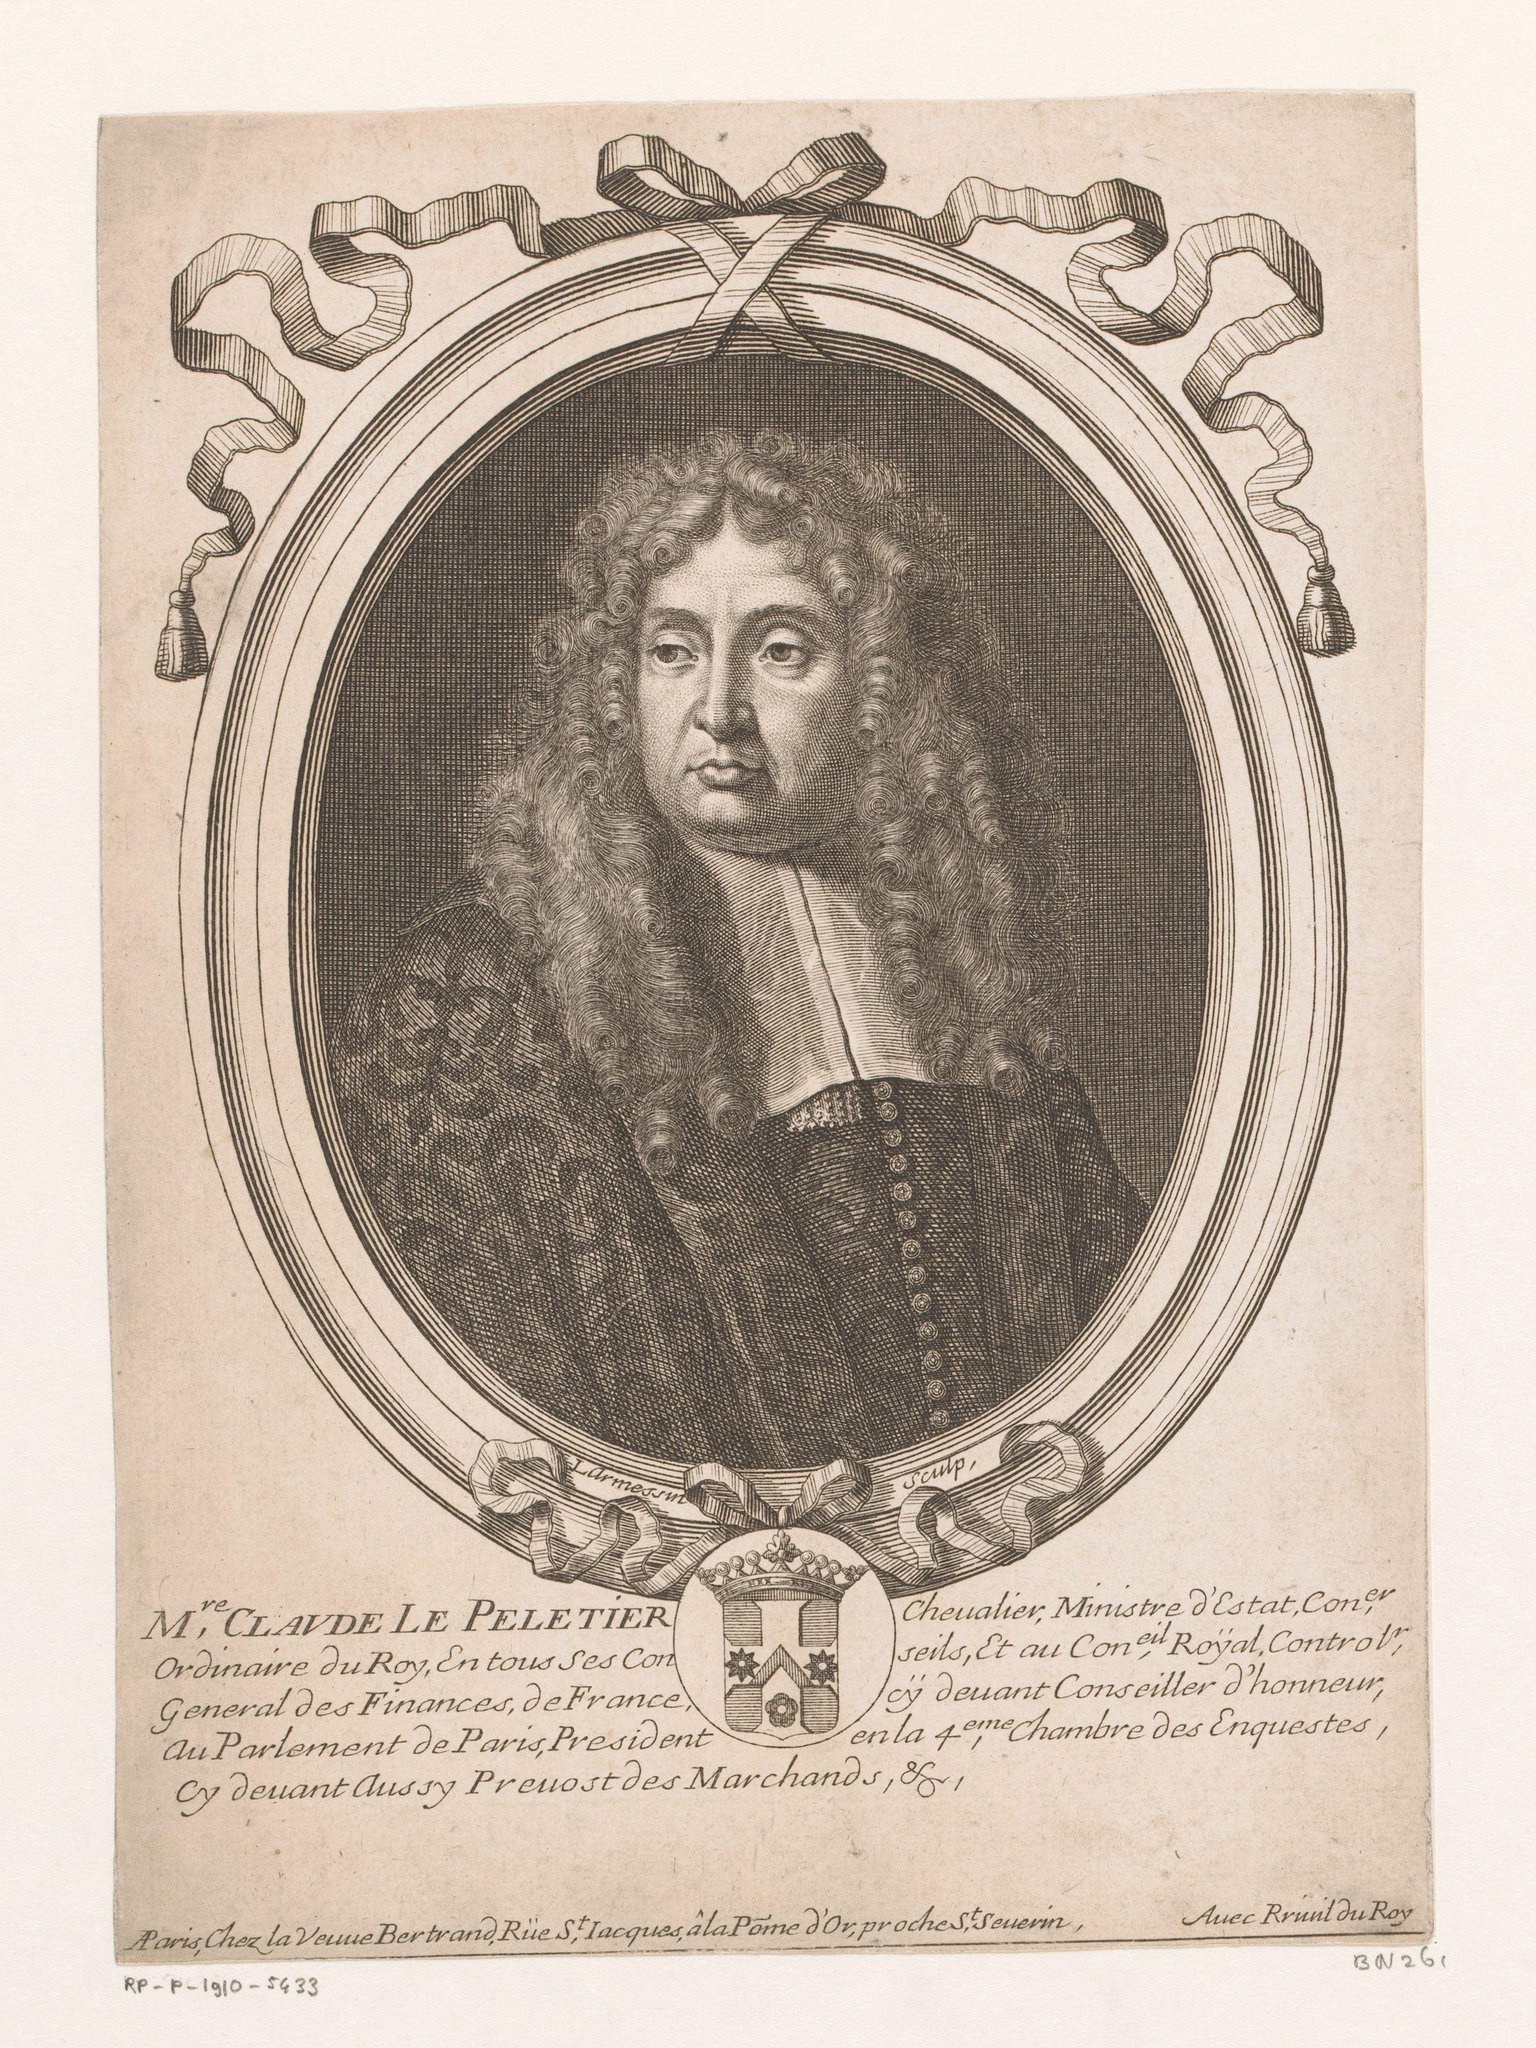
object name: print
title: Mre. Claude Le Peletier (...)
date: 1678-1694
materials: paper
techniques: engraving, etching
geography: france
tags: paris, historical persons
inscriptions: collector's mark: Lugt 2228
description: Maakt deel uit van een grootschalige serie met portretten van prominente figuren. Binnen de serie bevindt zich een sectie getiteld 'Les Augustes Représentations De tous les Roys De France depuis Pharamond Iusqu'à Louys XIIII'. De serie werd respectievelijk uitgegeven door Pierre Bertrand, door zijn weduwe en door De Larmessin zelf.